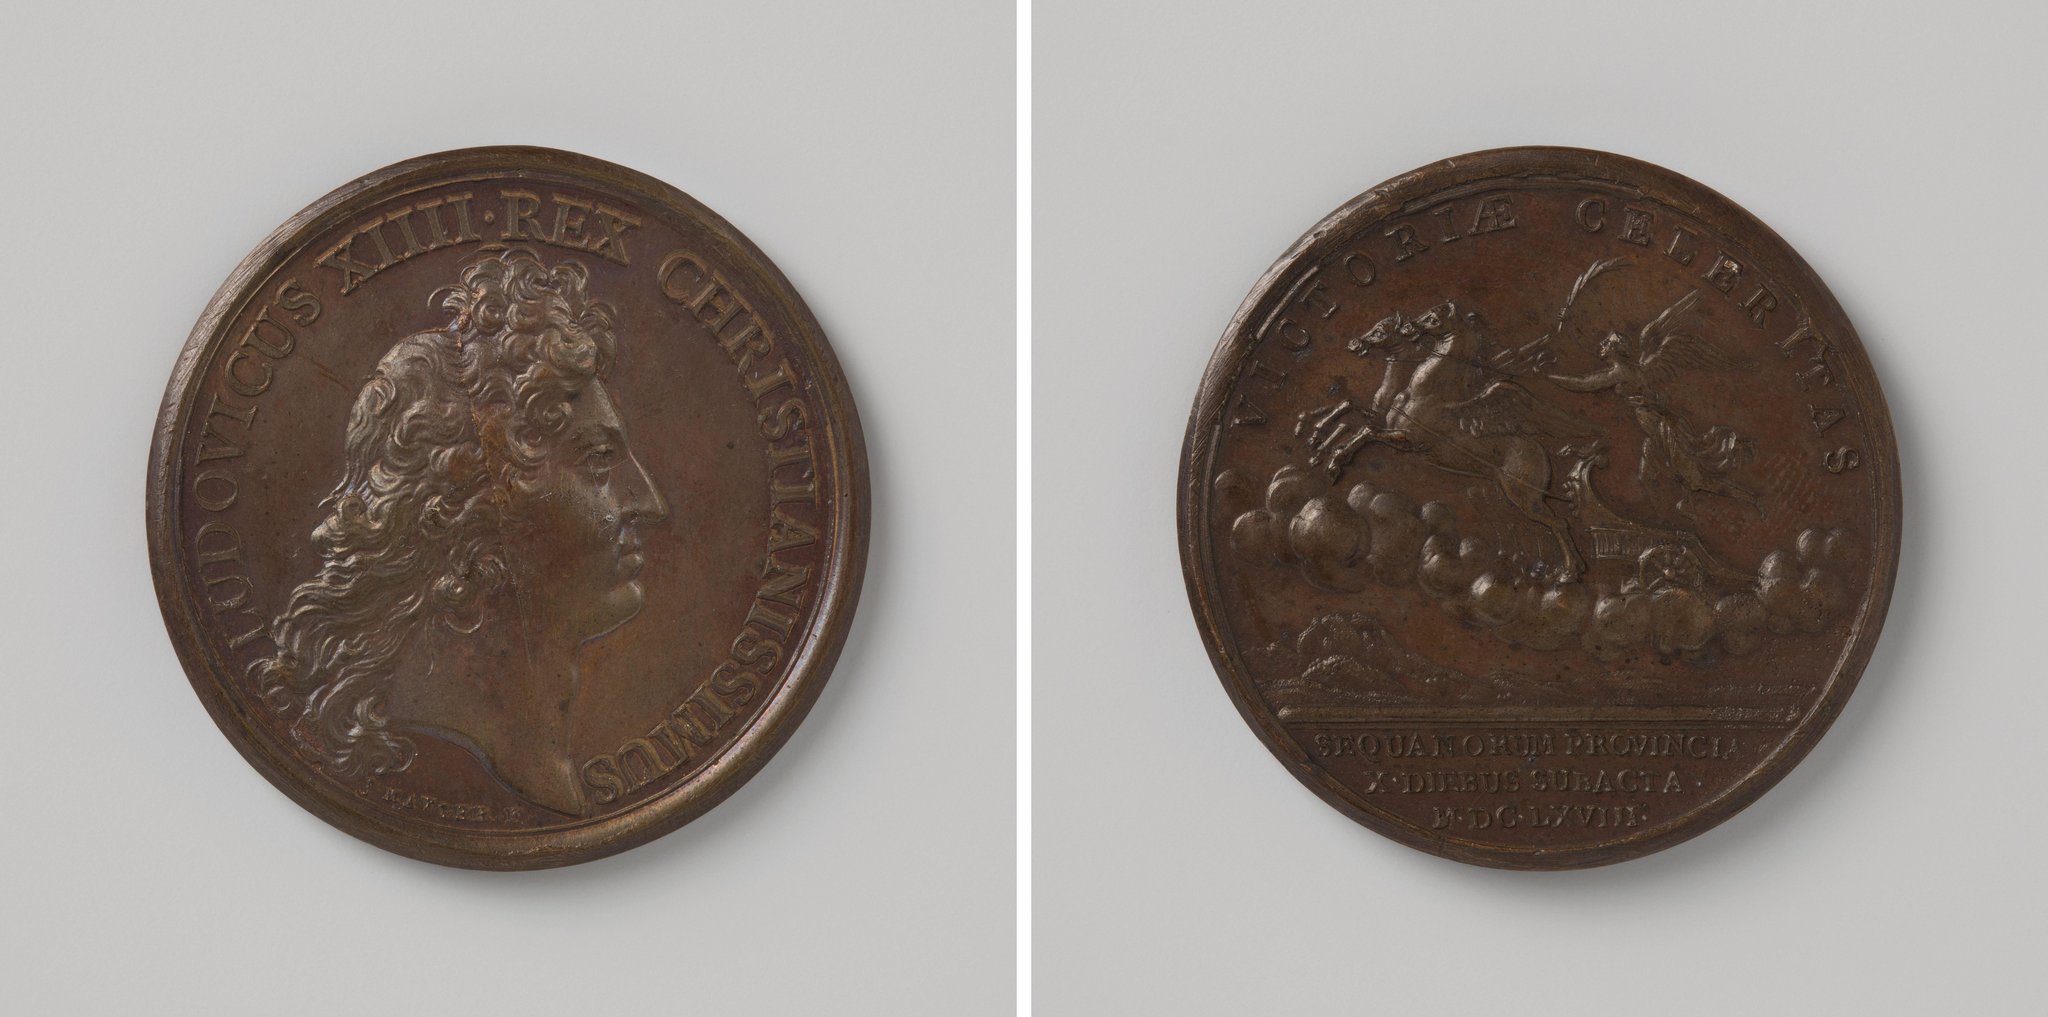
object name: history medal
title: Graafschap Bourgondië in tien dagen veroverd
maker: jean mauger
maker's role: medailleur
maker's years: 1648-1722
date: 1699-1703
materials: bronze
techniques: striking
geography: paris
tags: lodewijk xiv (koning van frankrijk)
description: Bronzen penning. Voorzijde: borststuk jongeman (Lodewijk XIV) binnen omschrift. Keerzijde: Overwinning ment vliegende wagen binnen omschrift.